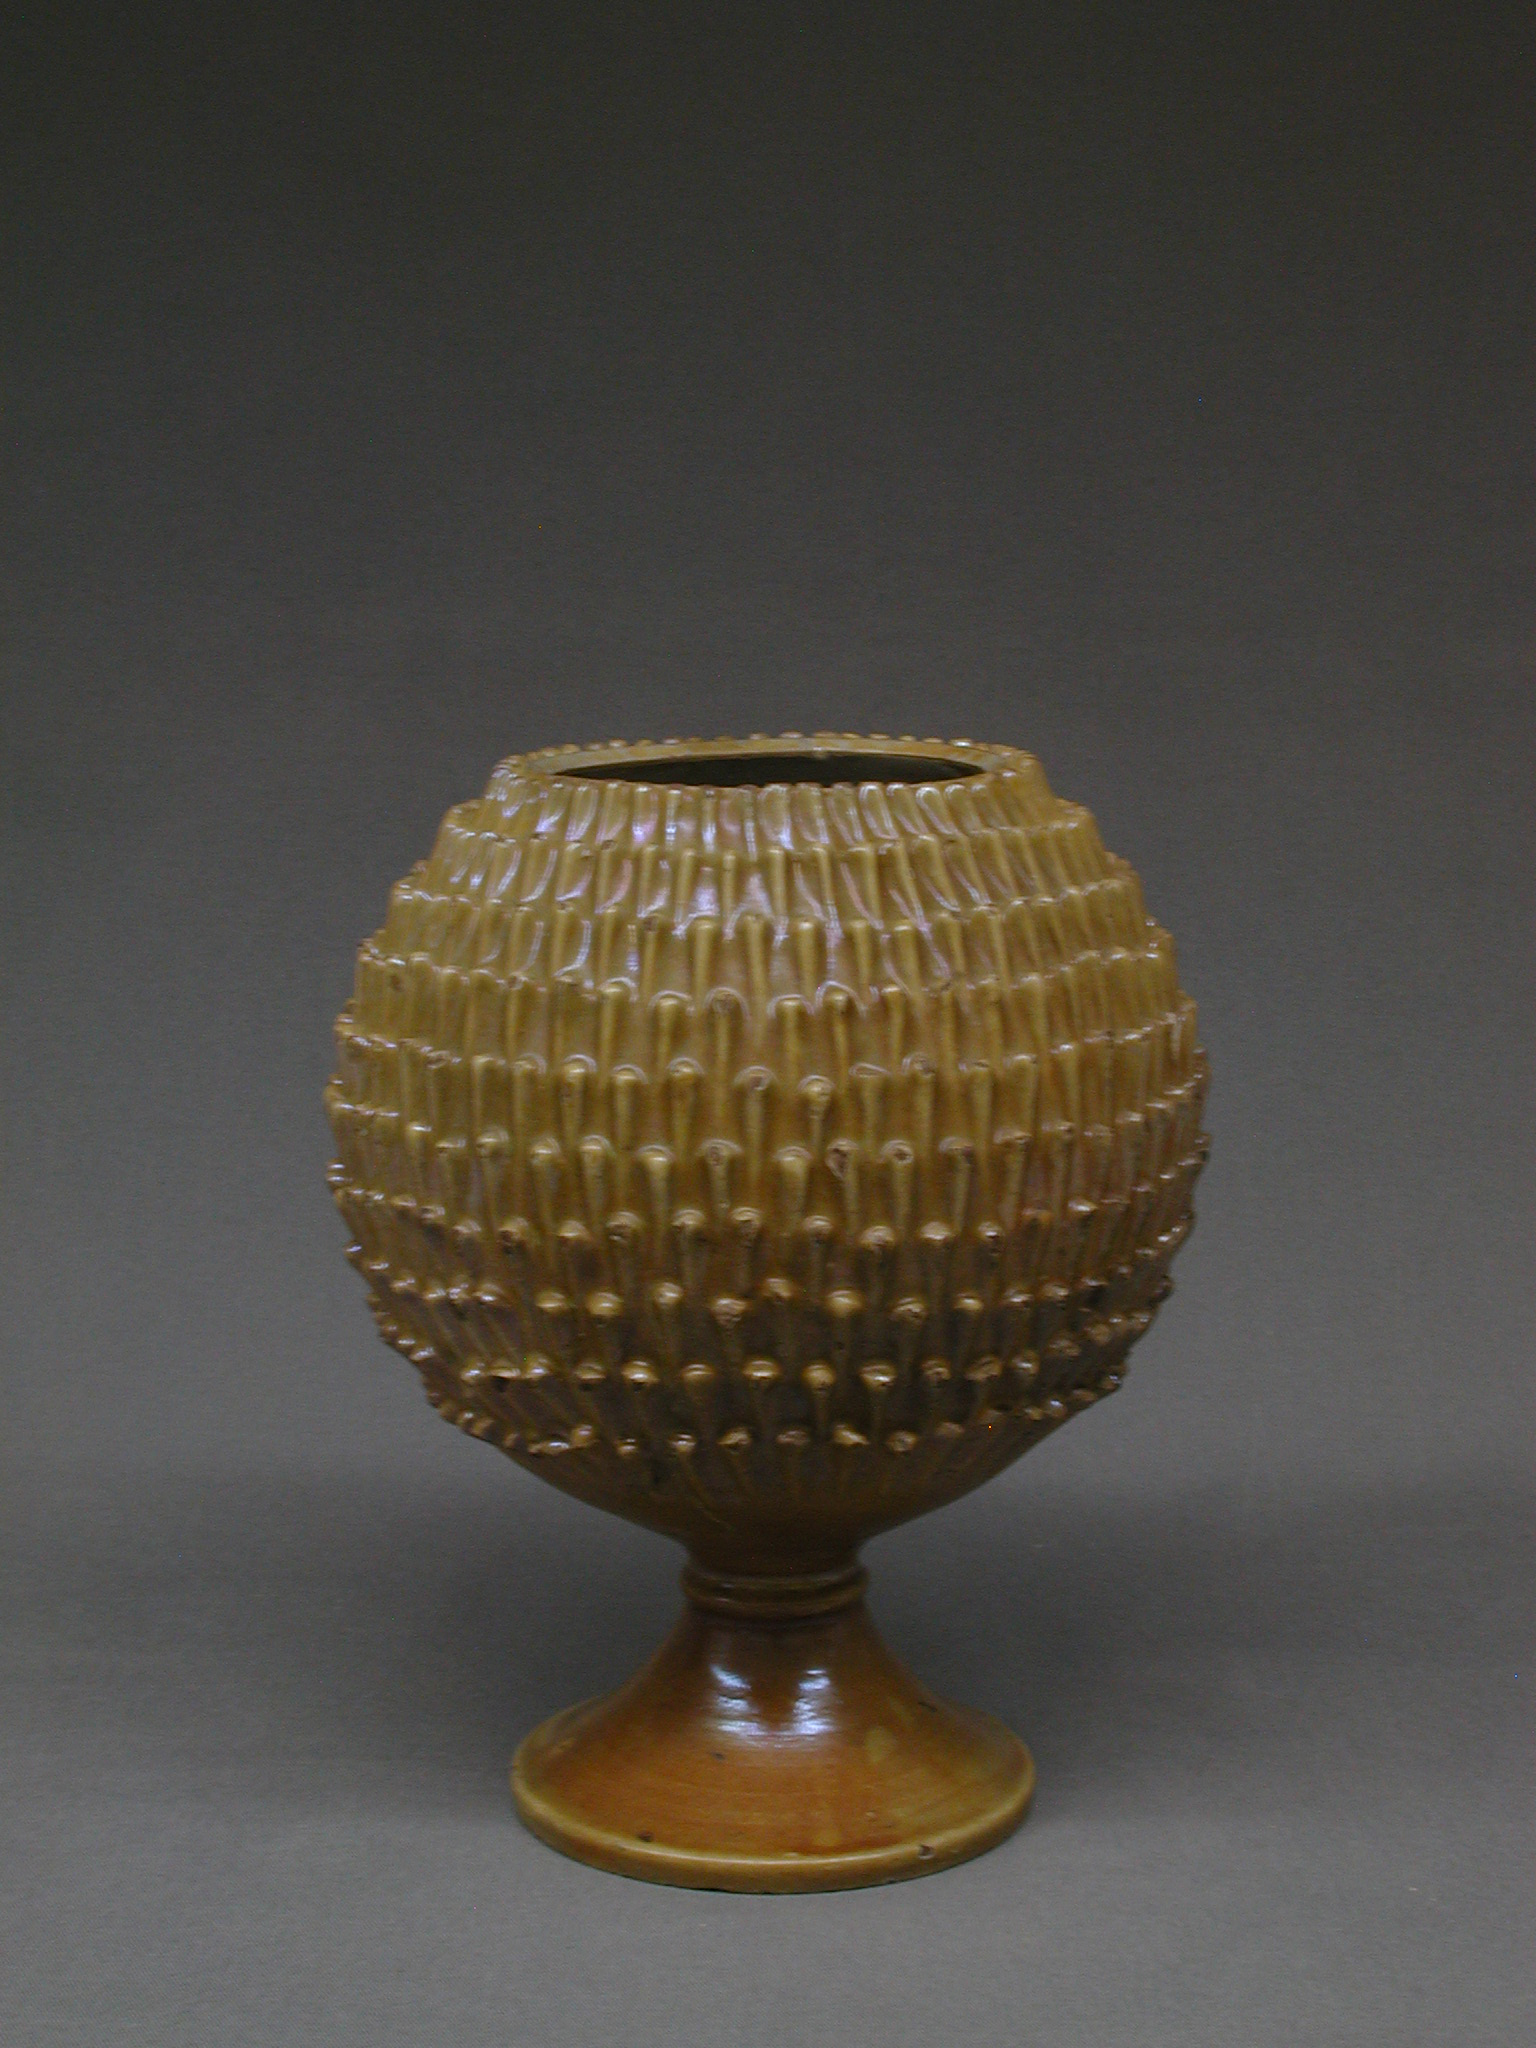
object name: cup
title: Pinecone cup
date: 1501-1550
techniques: maiolica, glazing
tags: pinecones